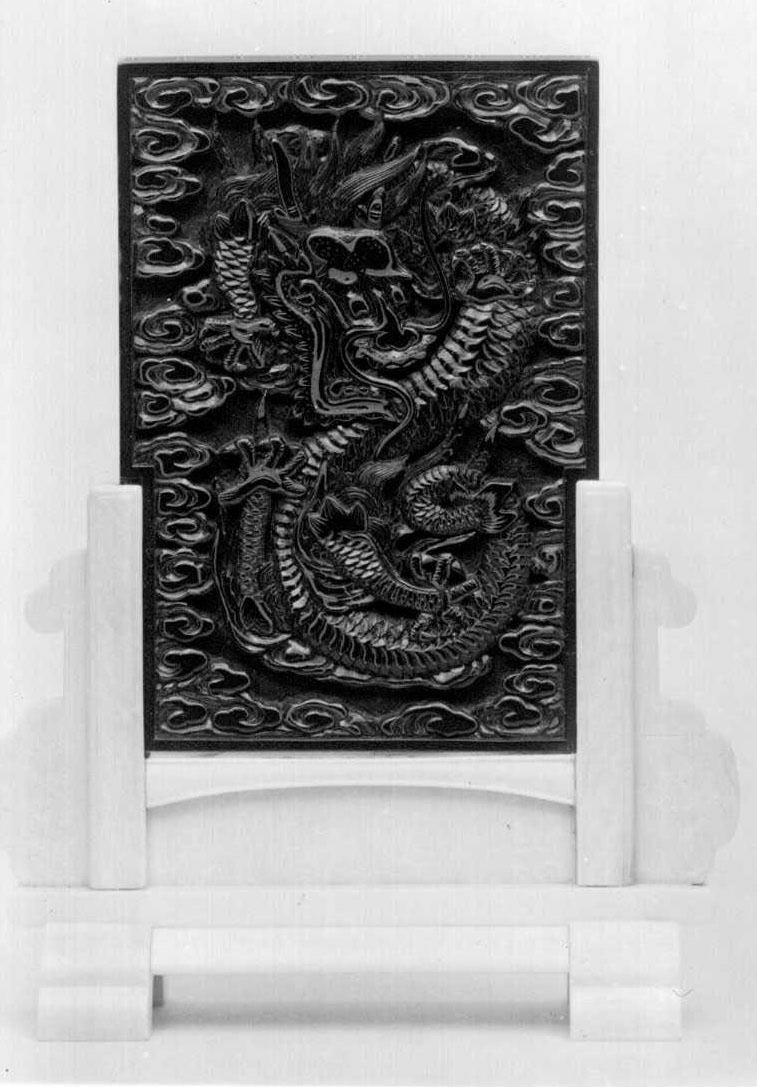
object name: desk screen on stand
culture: chinese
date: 1368-1378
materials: lacquer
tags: dragons